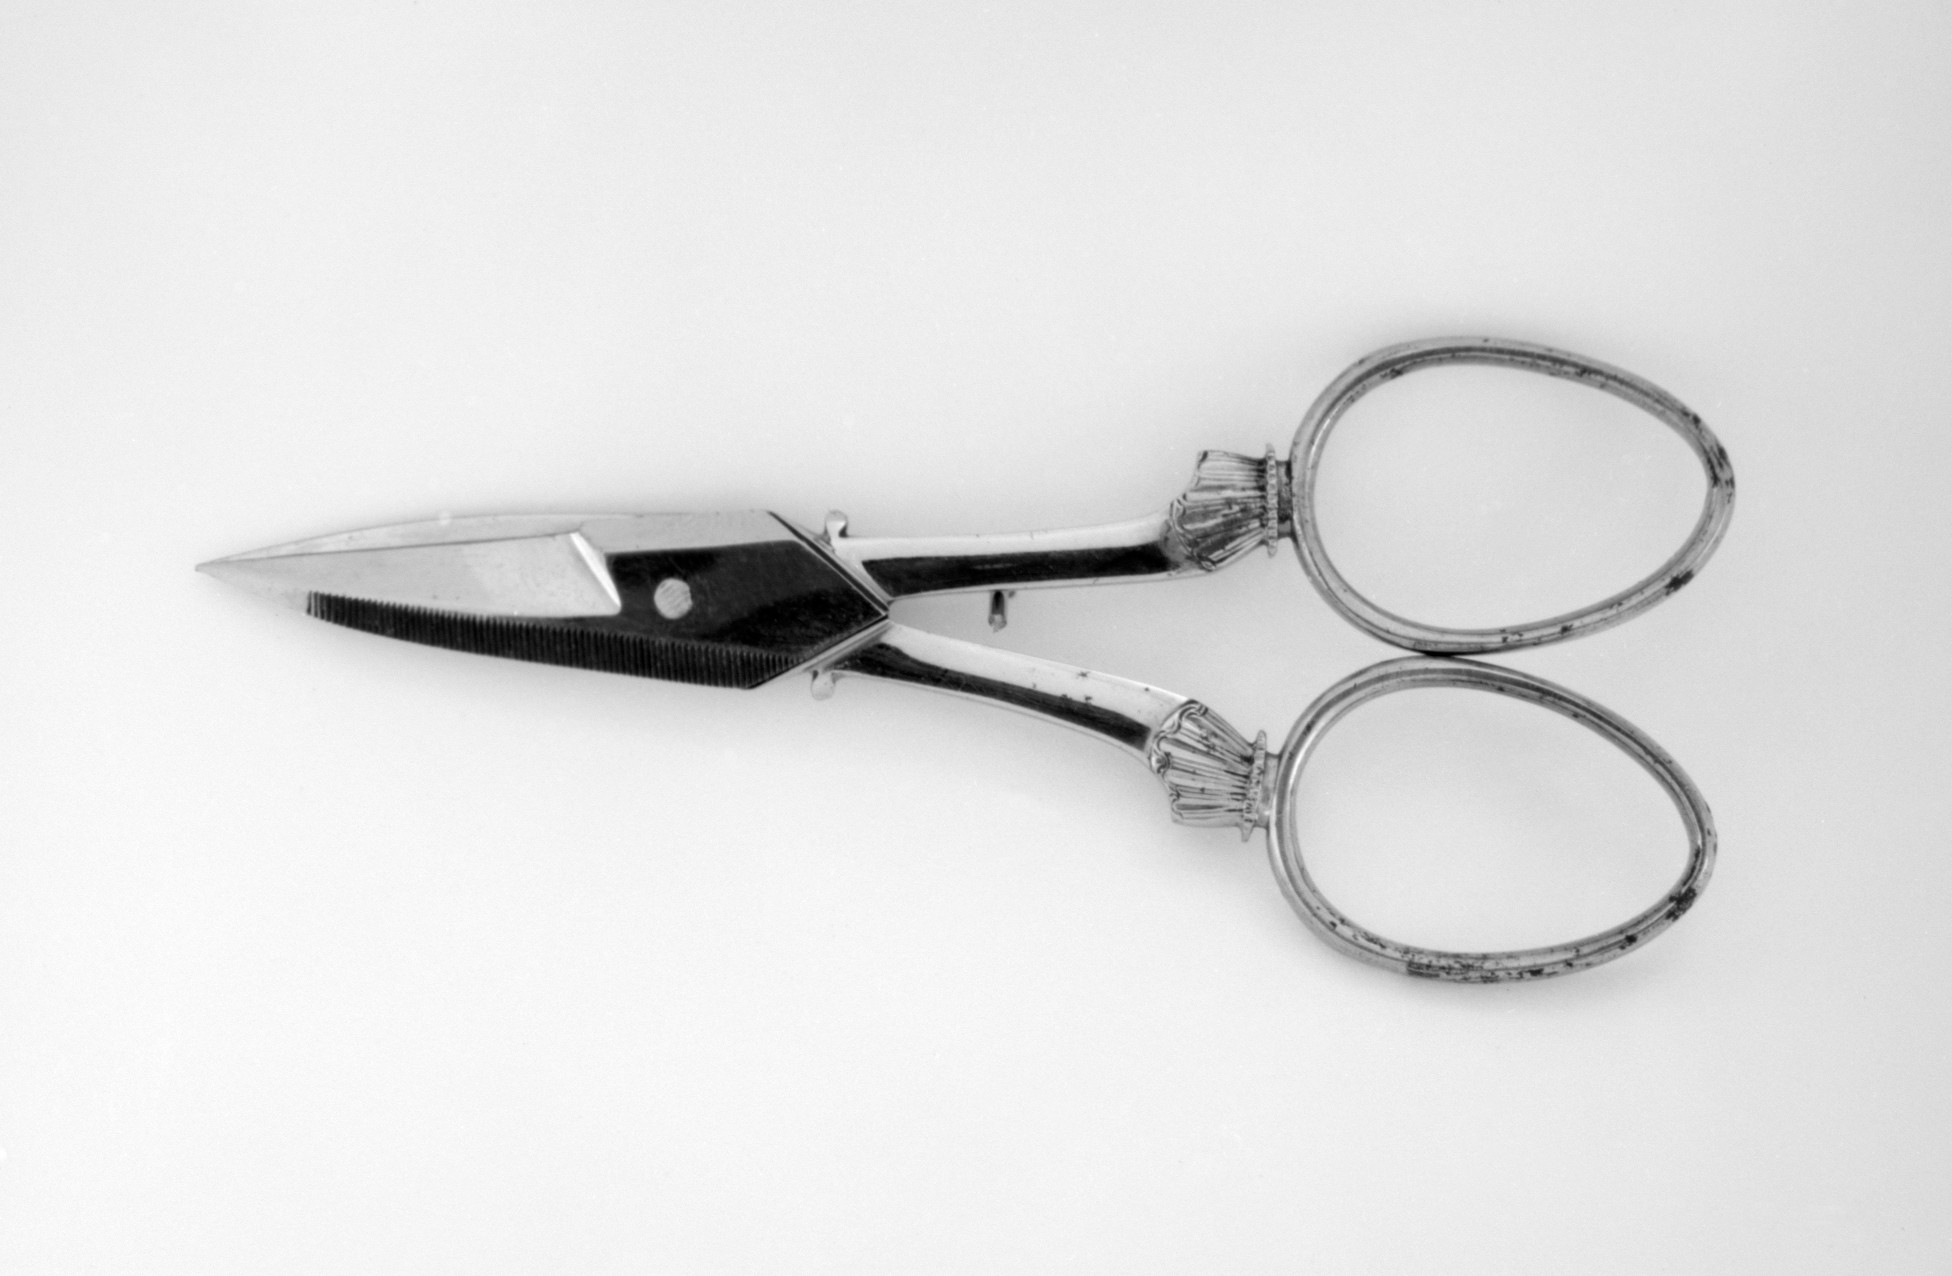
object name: scissors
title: Scissors (part of a set)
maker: j. hobson & son, england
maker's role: maker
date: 1848-1849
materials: steel